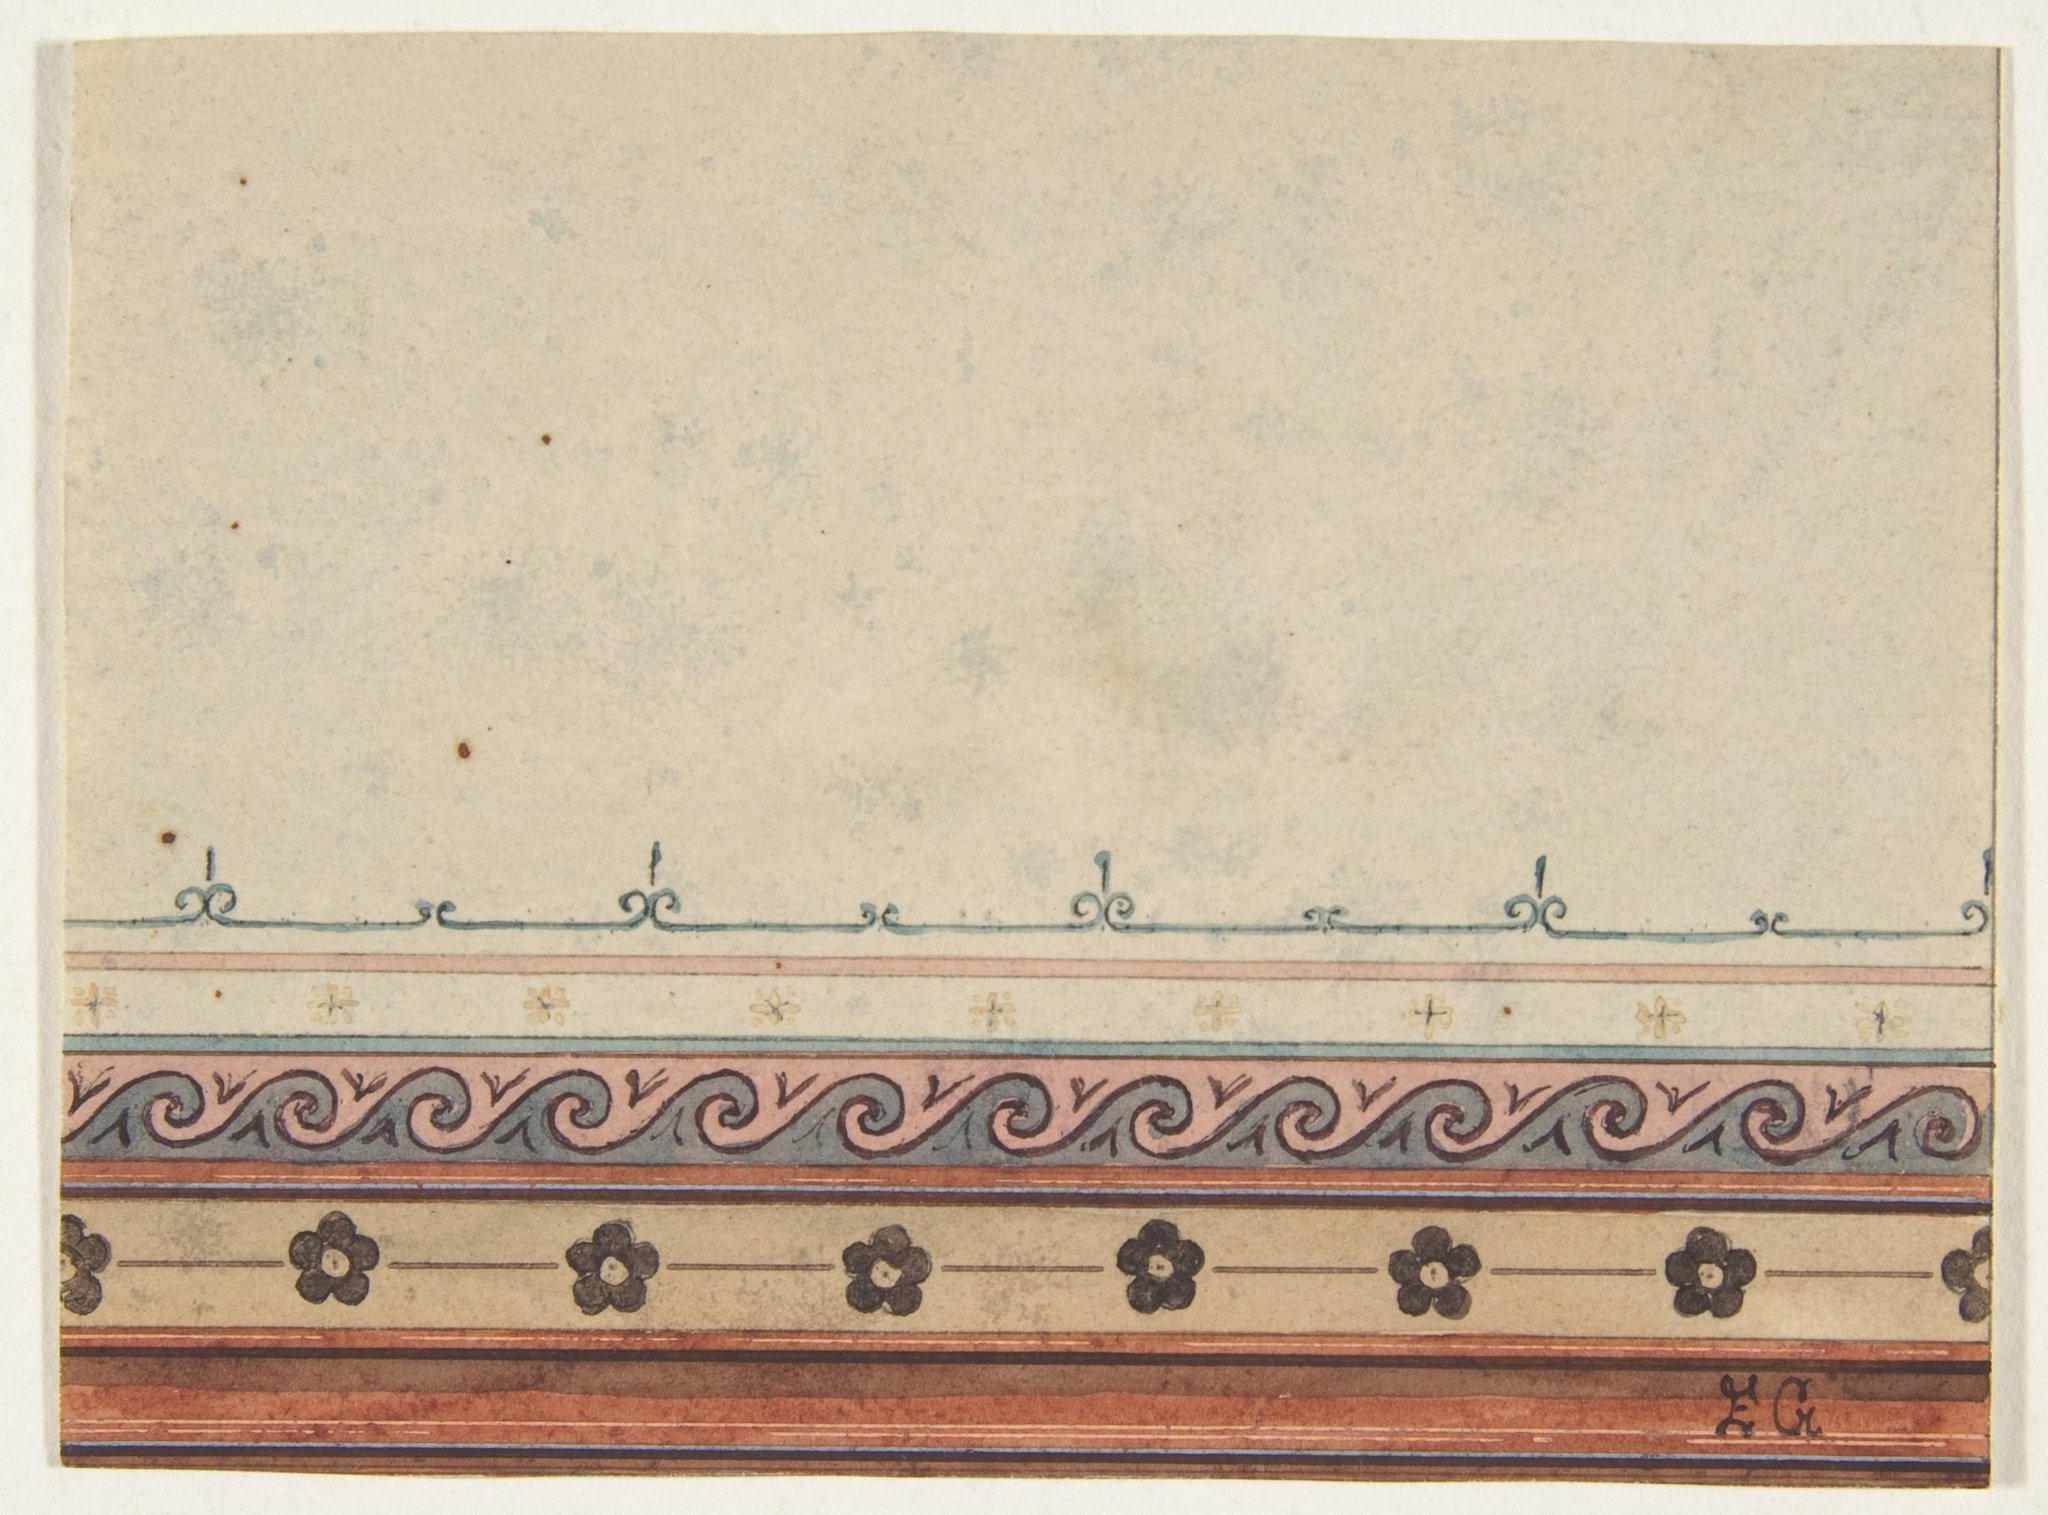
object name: drawing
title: Design for the decoration of a ceiling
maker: jules-edmond-charles lachaise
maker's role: artist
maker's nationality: french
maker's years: 1897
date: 1851-1900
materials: ink, watercolor, paper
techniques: pen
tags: flowers